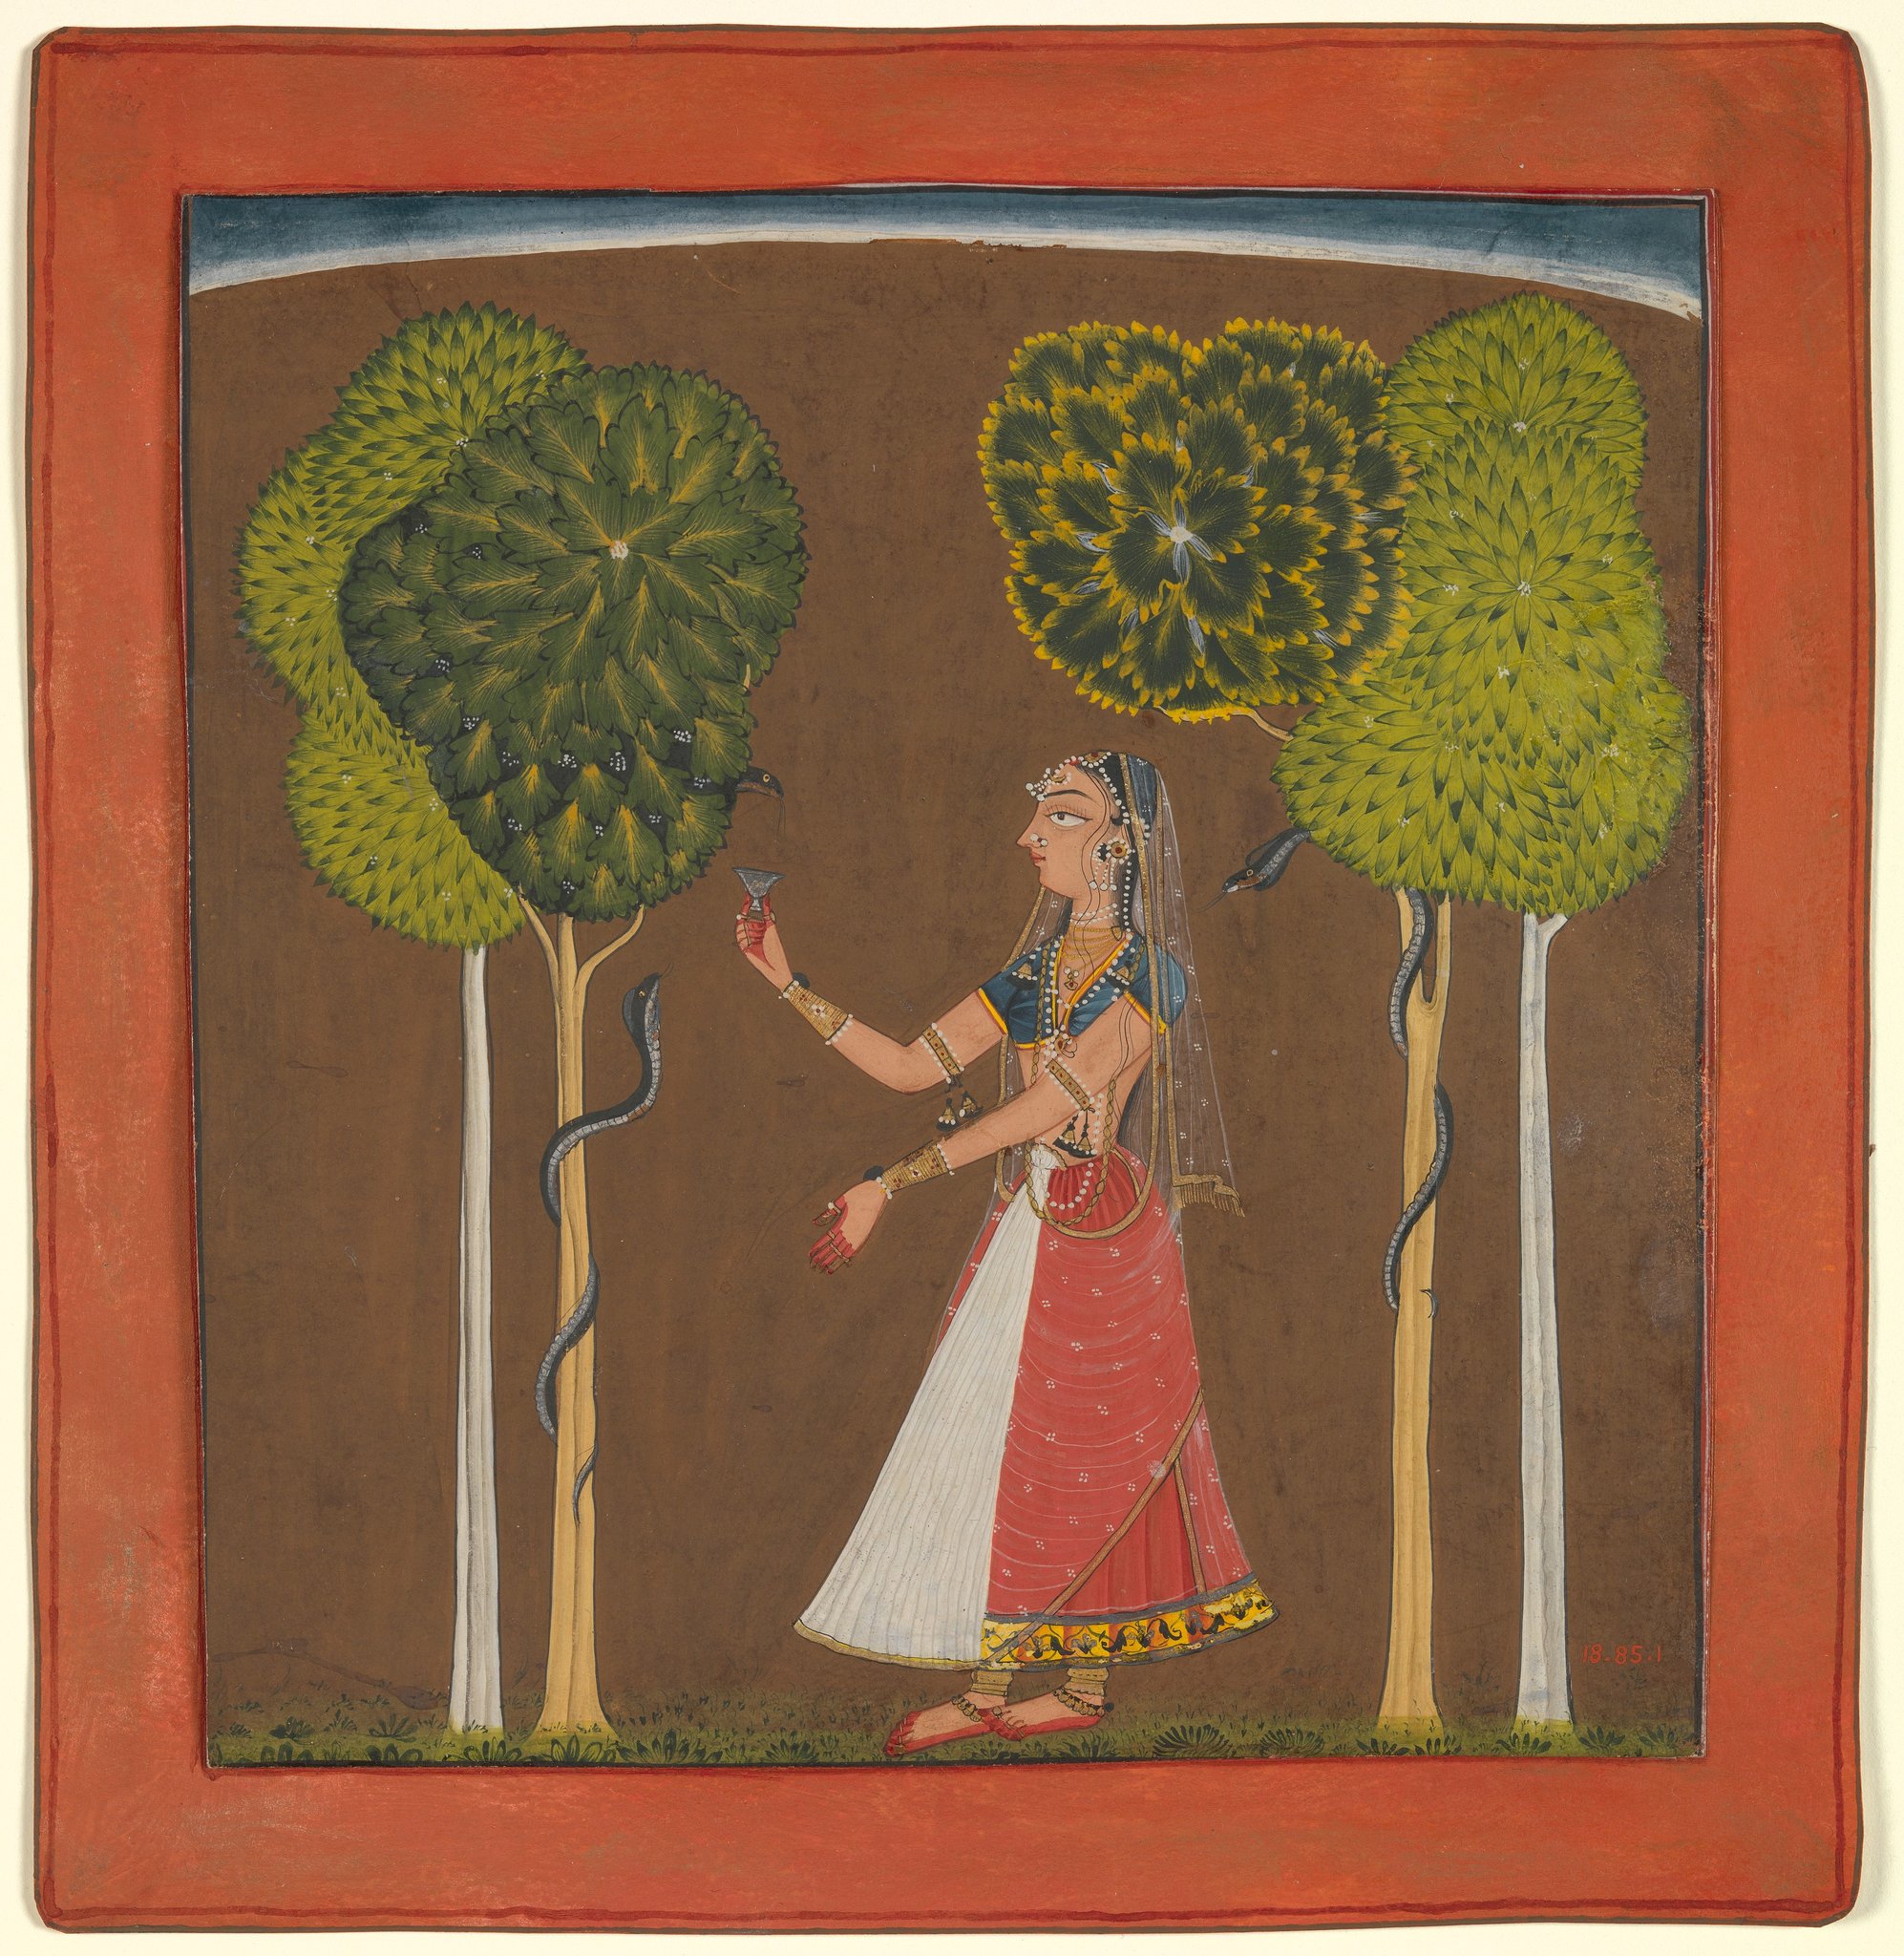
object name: folio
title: Ragini, possibly Asavari: Folio from a Ragamala Series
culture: indian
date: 1700-1710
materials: ink, paper, watercolor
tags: women,snakes,trees